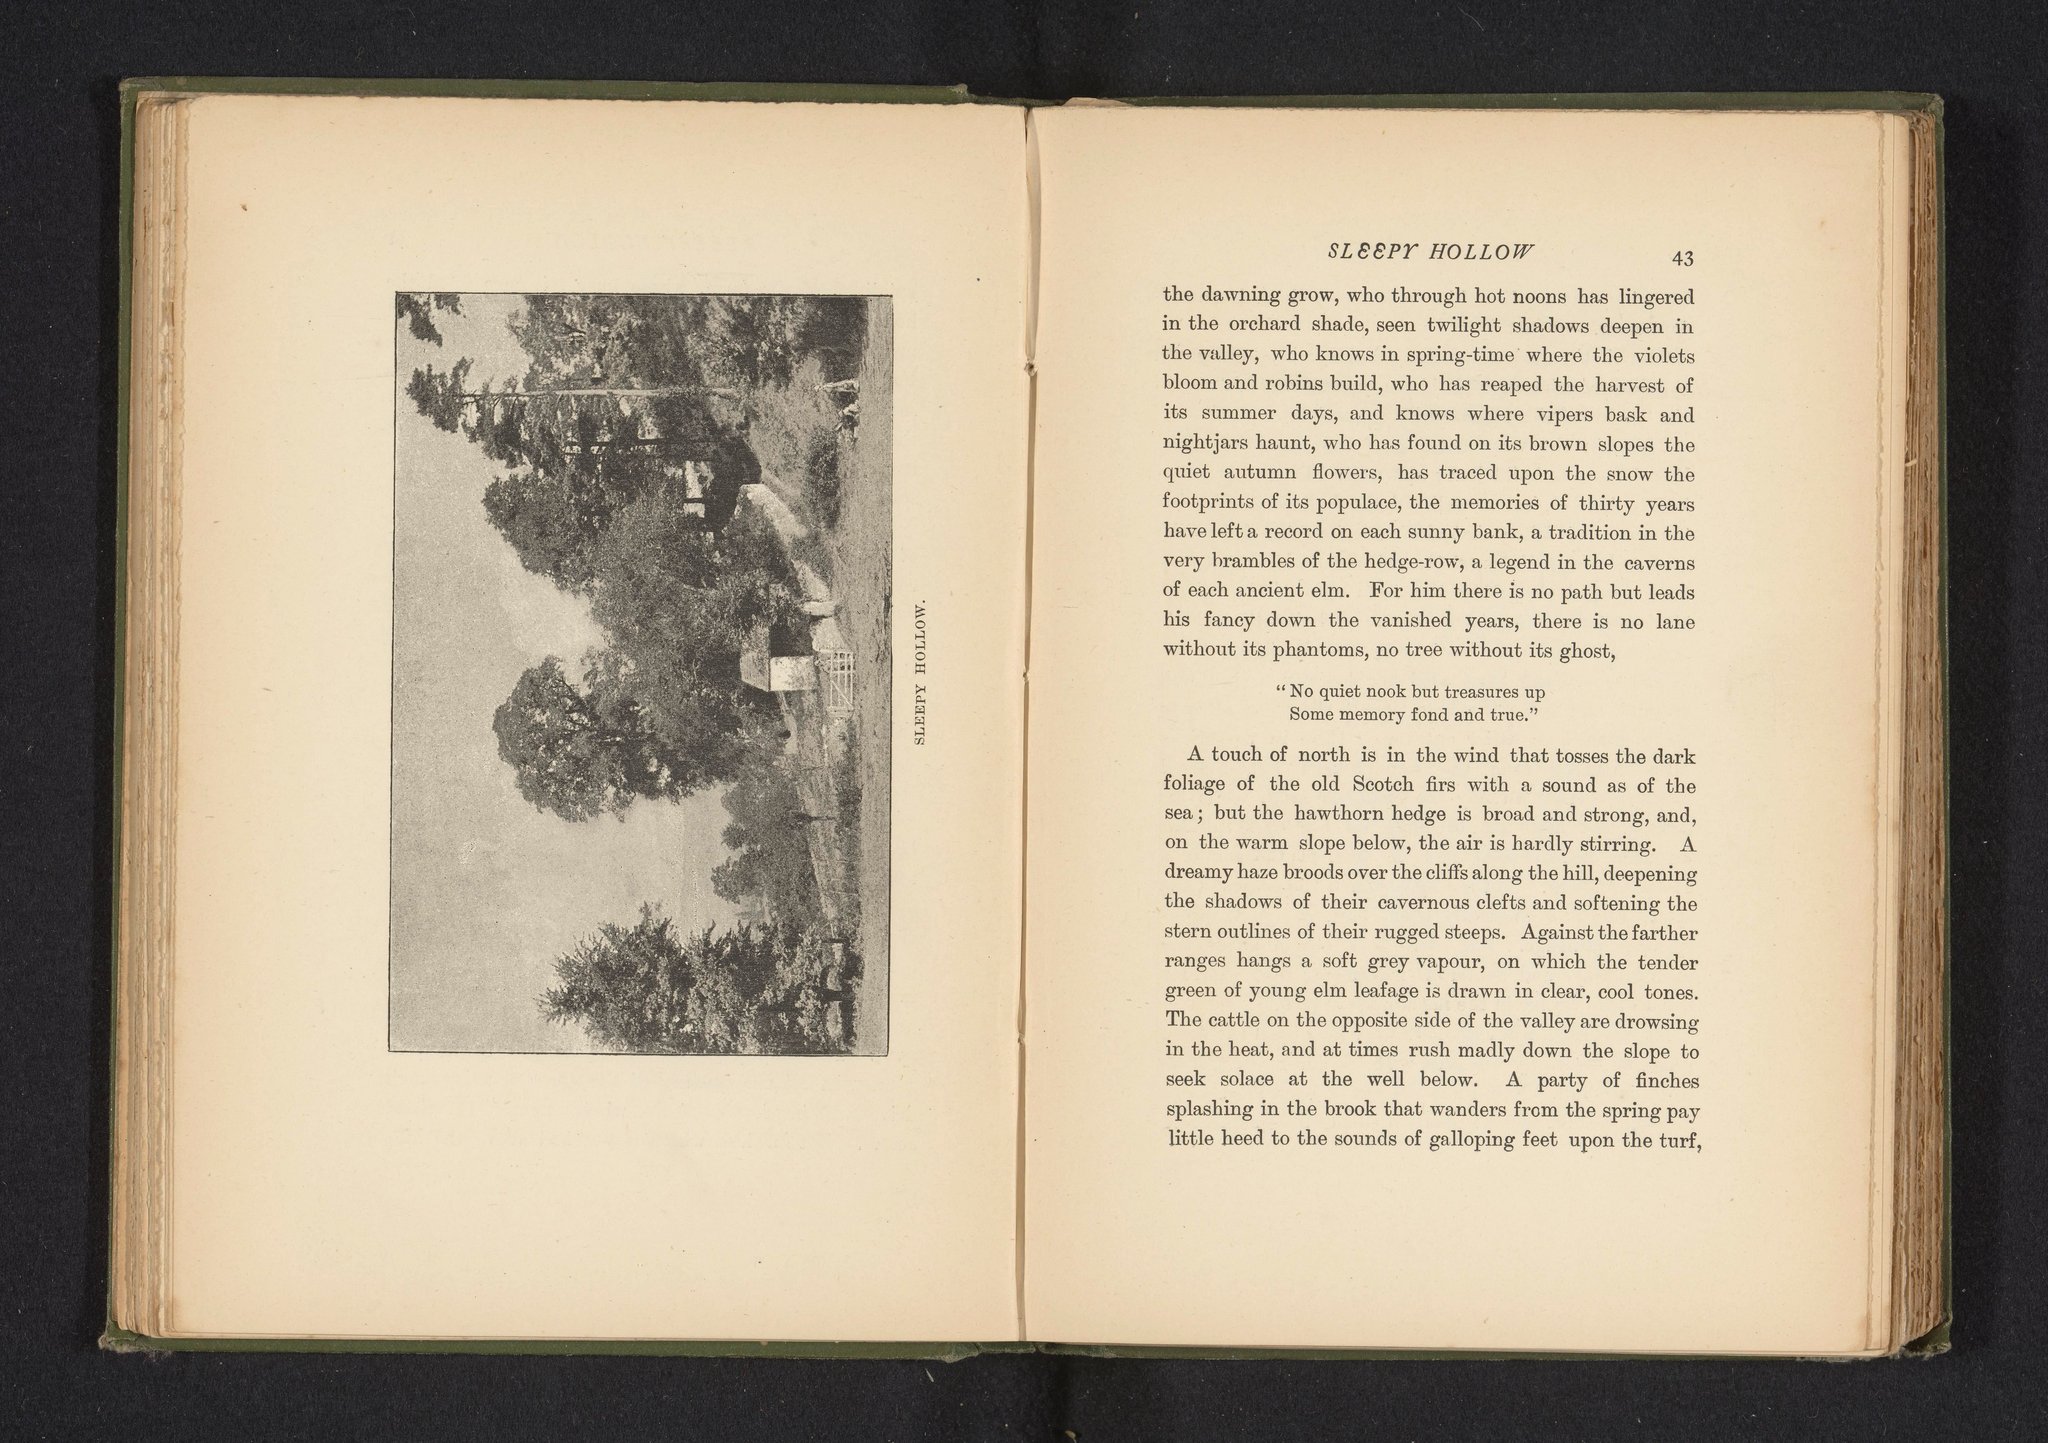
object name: page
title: Sleepy Hollow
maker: Anonymous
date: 1886-1891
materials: paper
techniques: autotype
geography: wales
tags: meadow, pasture